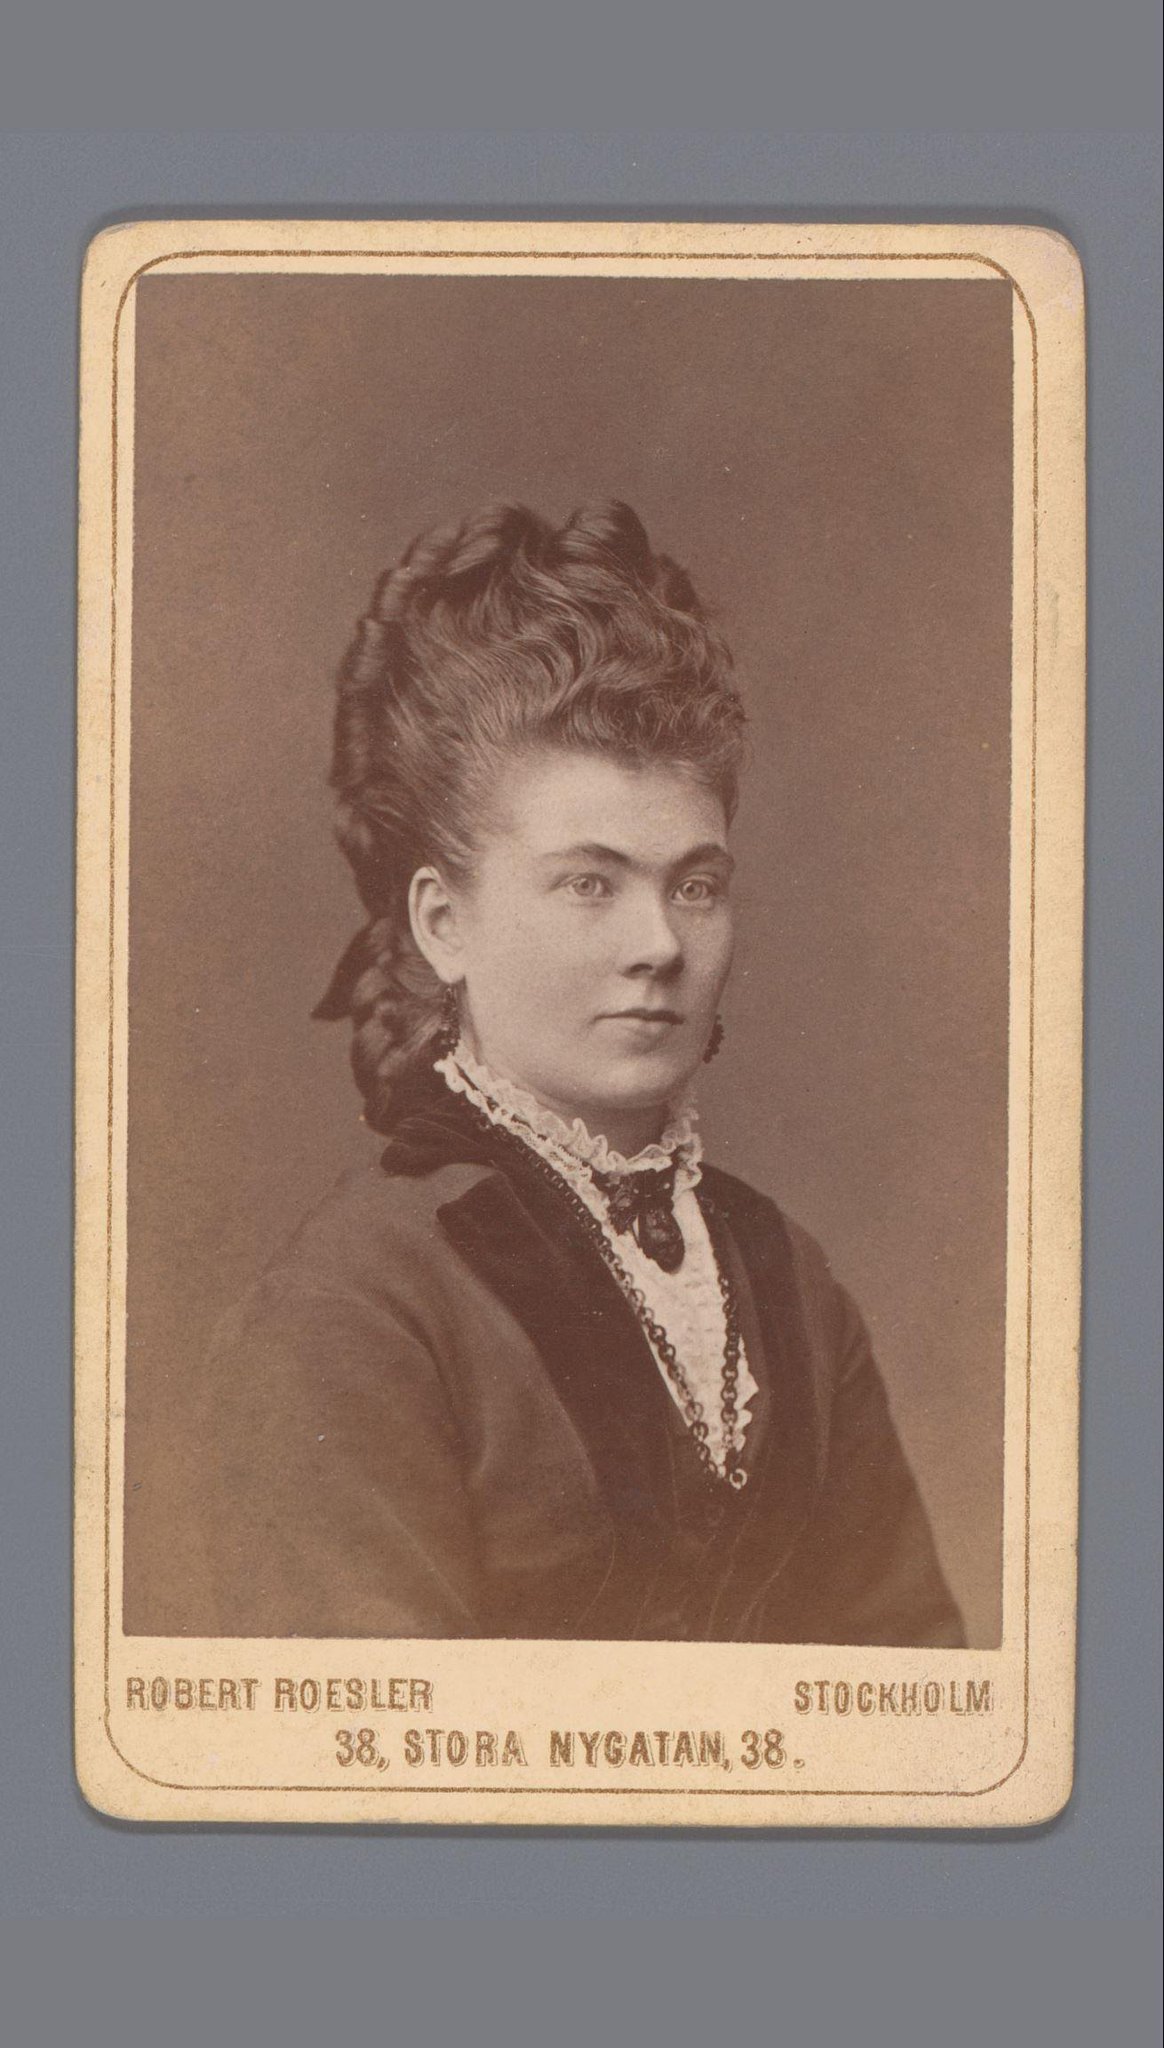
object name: carte de visite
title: Portret van een onbekende vrouw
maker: august roesler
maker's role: fotograaf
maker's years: 1837-1896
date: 1870-1880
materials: cardboard, paper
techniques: albumen print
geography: stockholm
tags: historical persons - bb - woman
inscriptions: inscription: ‘Fotografi/ af/ R. ROESLER/ STOCKHOLM/ 38/ Stora Nygatan/ Plåten förvaras för efterbeställning’, address: ‘ROBERT ROESLER/ STOCKHOLM/ 38, STORA NYGATAN, 38.’